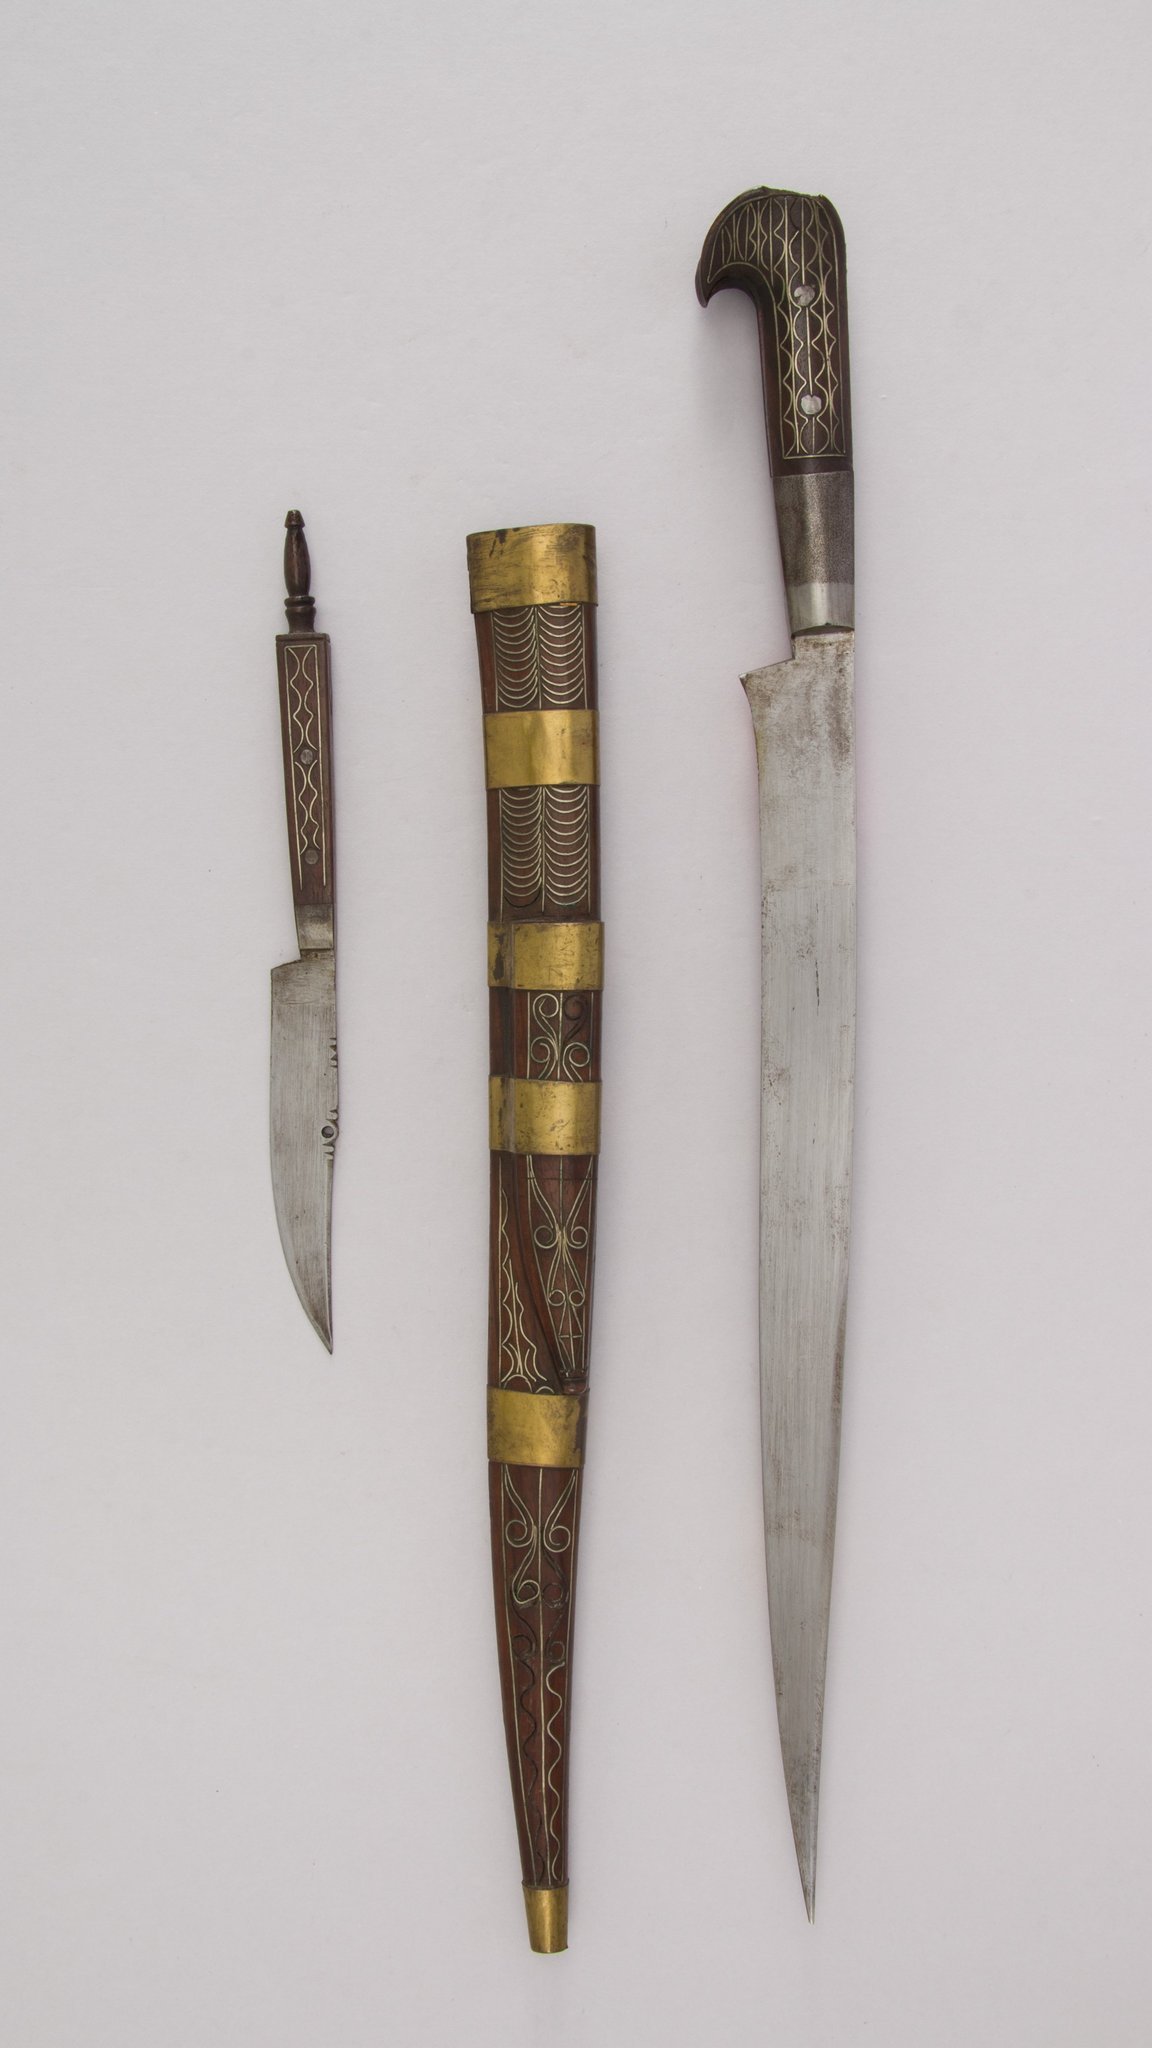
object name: knife with sheath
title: Knife with Sheath and Small Knife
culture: algerian or kabyle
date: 1801-1900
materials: brass, silver, steel, metal, wood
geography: algeria